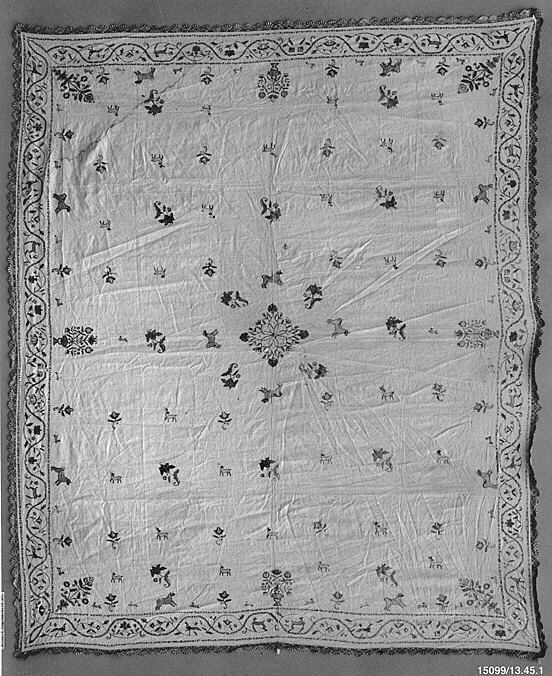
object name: cover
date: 1701-1800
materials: linen, silk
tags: animals